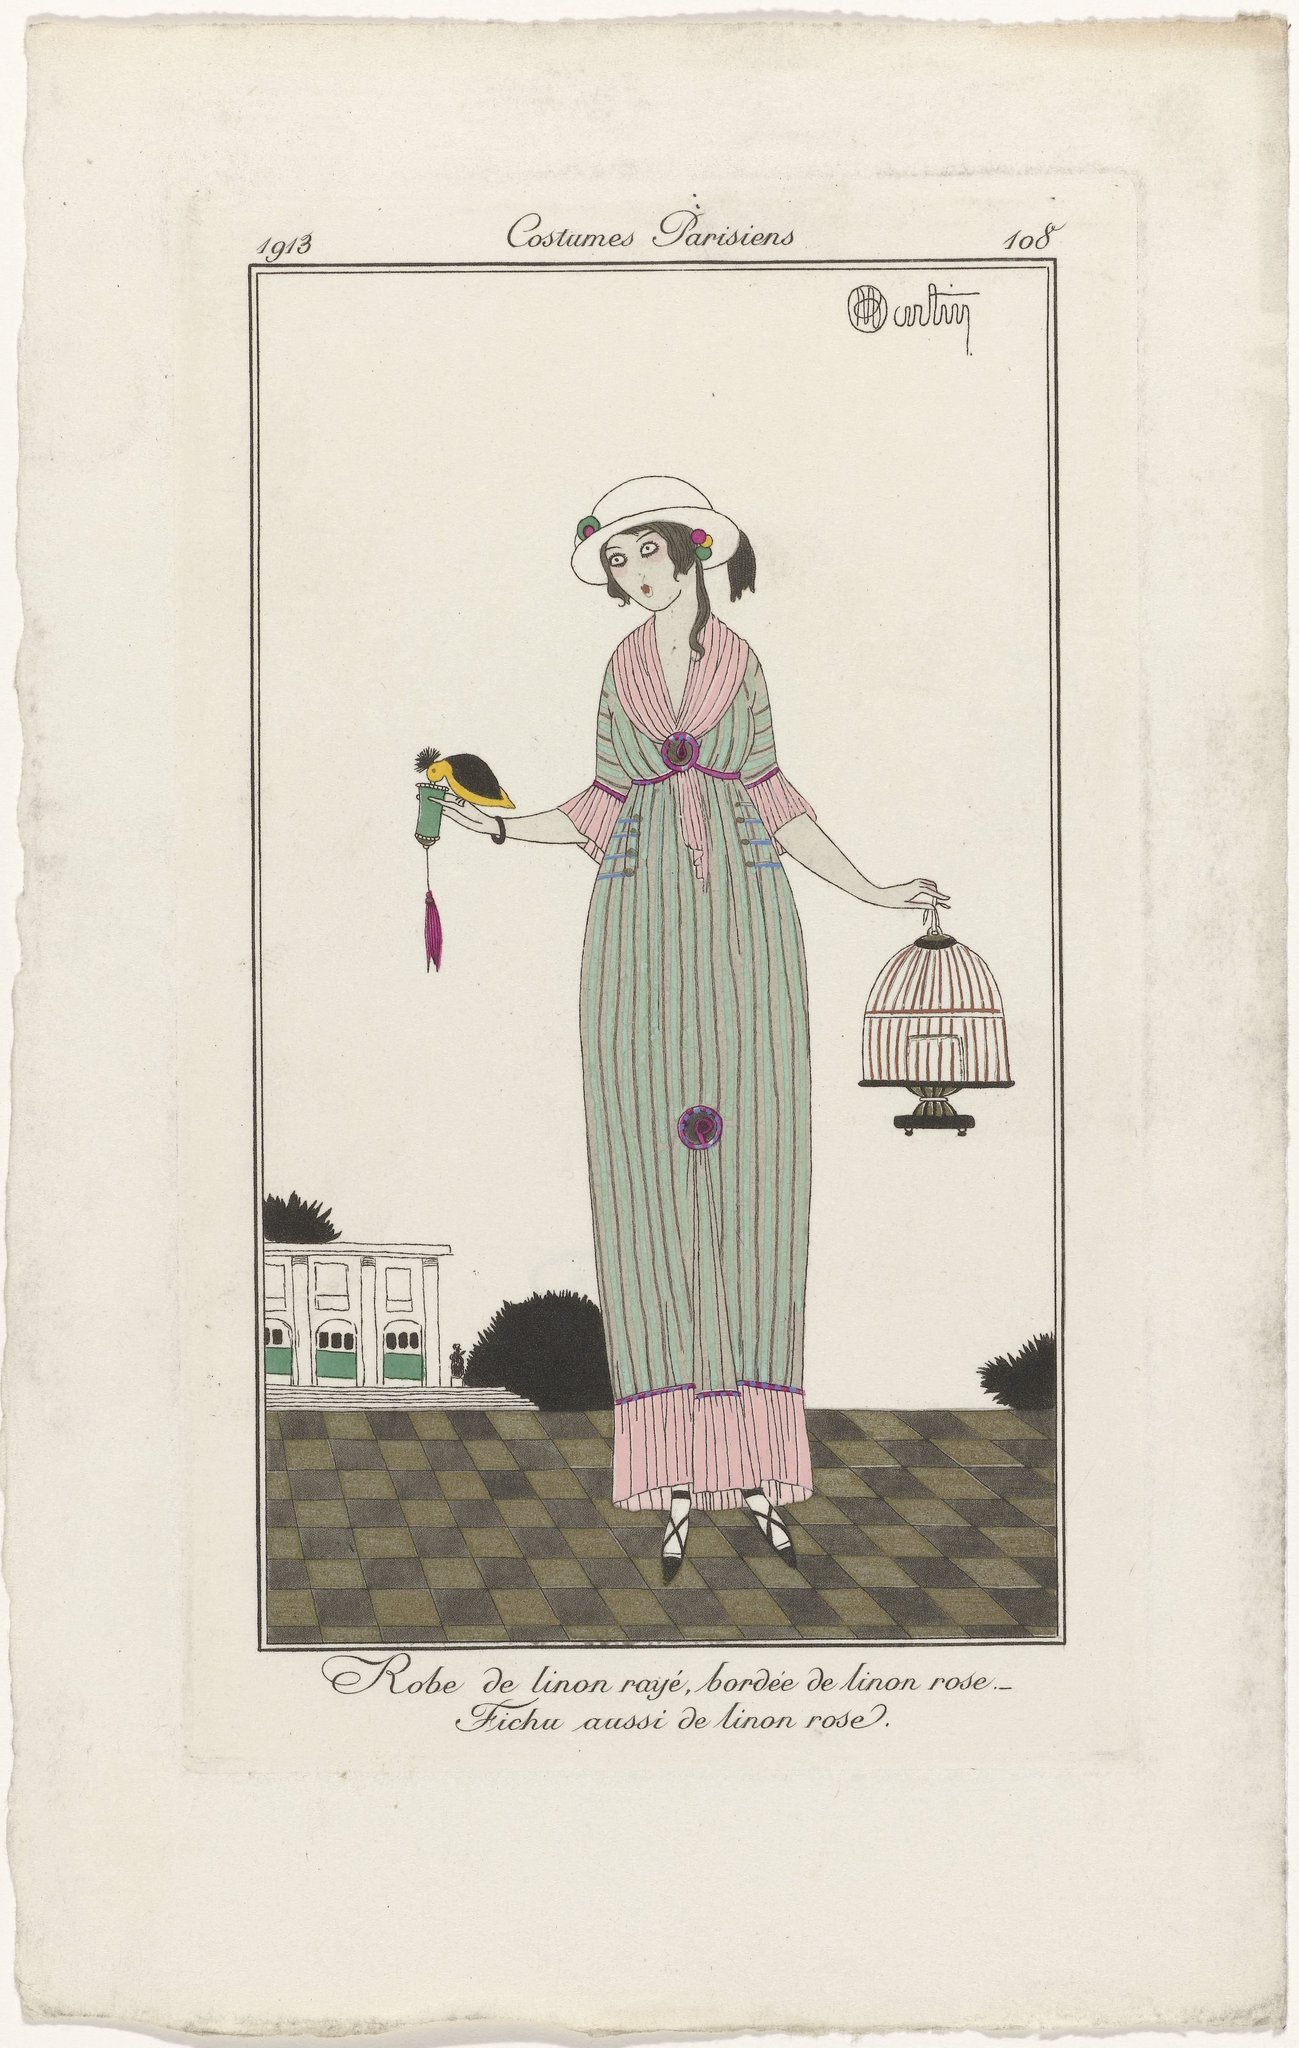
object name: fashion print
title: Journal des Dames et des Modes, Costumes Parisiens, 1913, No. 108 : Robe de linon (...)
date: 1913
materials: paper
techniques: engraving, hand coloring, pochoir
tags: empty bird cage, birds (+ man and animal), feeding wild animals (+ variant), fashion plates, head-gear: hat (+ women's clothes), dress, gown (+ women's clothes), piece of clothing covering the breast or décolleté (fichu) (+ women's clothes)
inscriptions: caption: ‘Robe de linon rayé, bordée de linon rose_ fichu aussi de linon rose.’, title: ‘Costumes Parisiens’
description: Vrouw in een jurk van gestreept linnen, afgezet met roze linnen. Fichu ook van roze linnen. In één hand heeft zij een vogelkooi en in de andere hand een voederbakje met vogel. Prent uit het modetijdschrift Journal des Dames et des Modes (1912-1914).